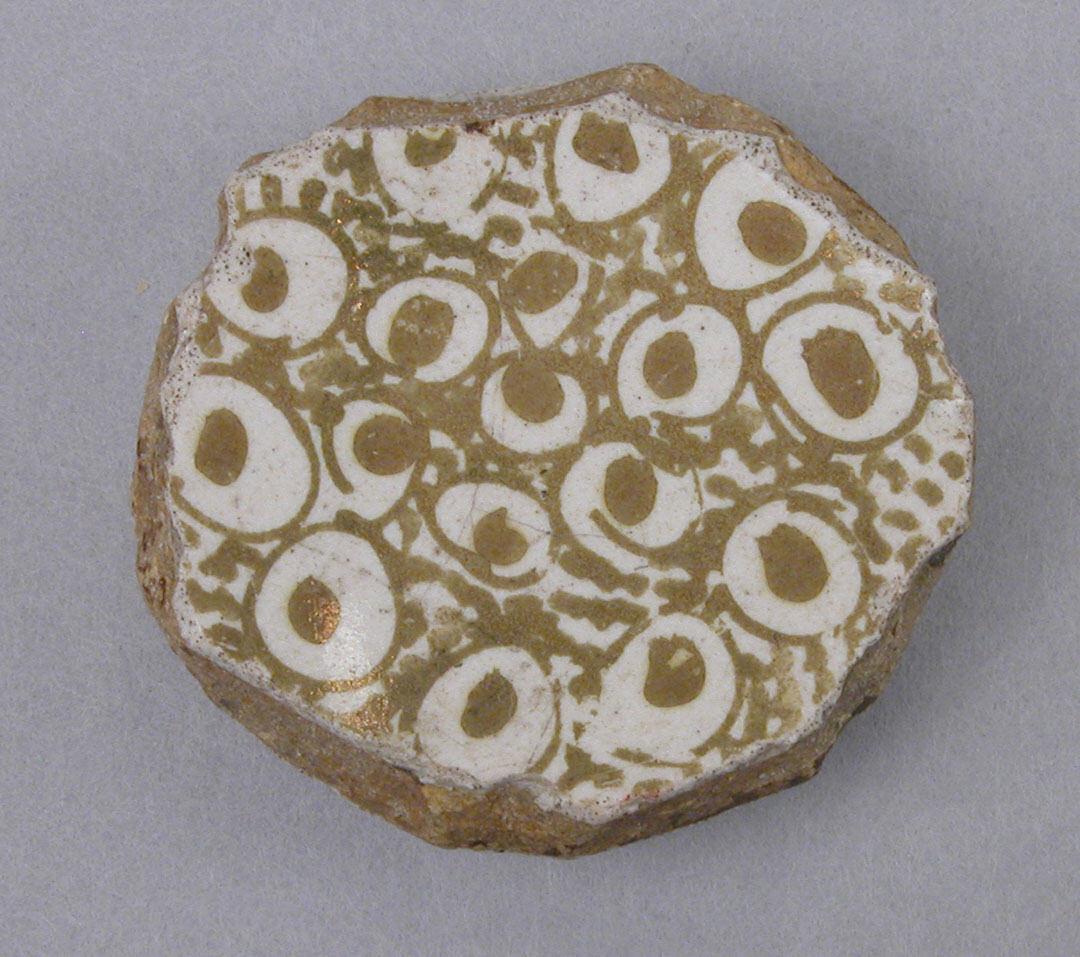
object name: fragment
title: Ceramic Fragment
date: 901-1000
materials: glaze, stonepaste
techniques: painting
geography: iraq